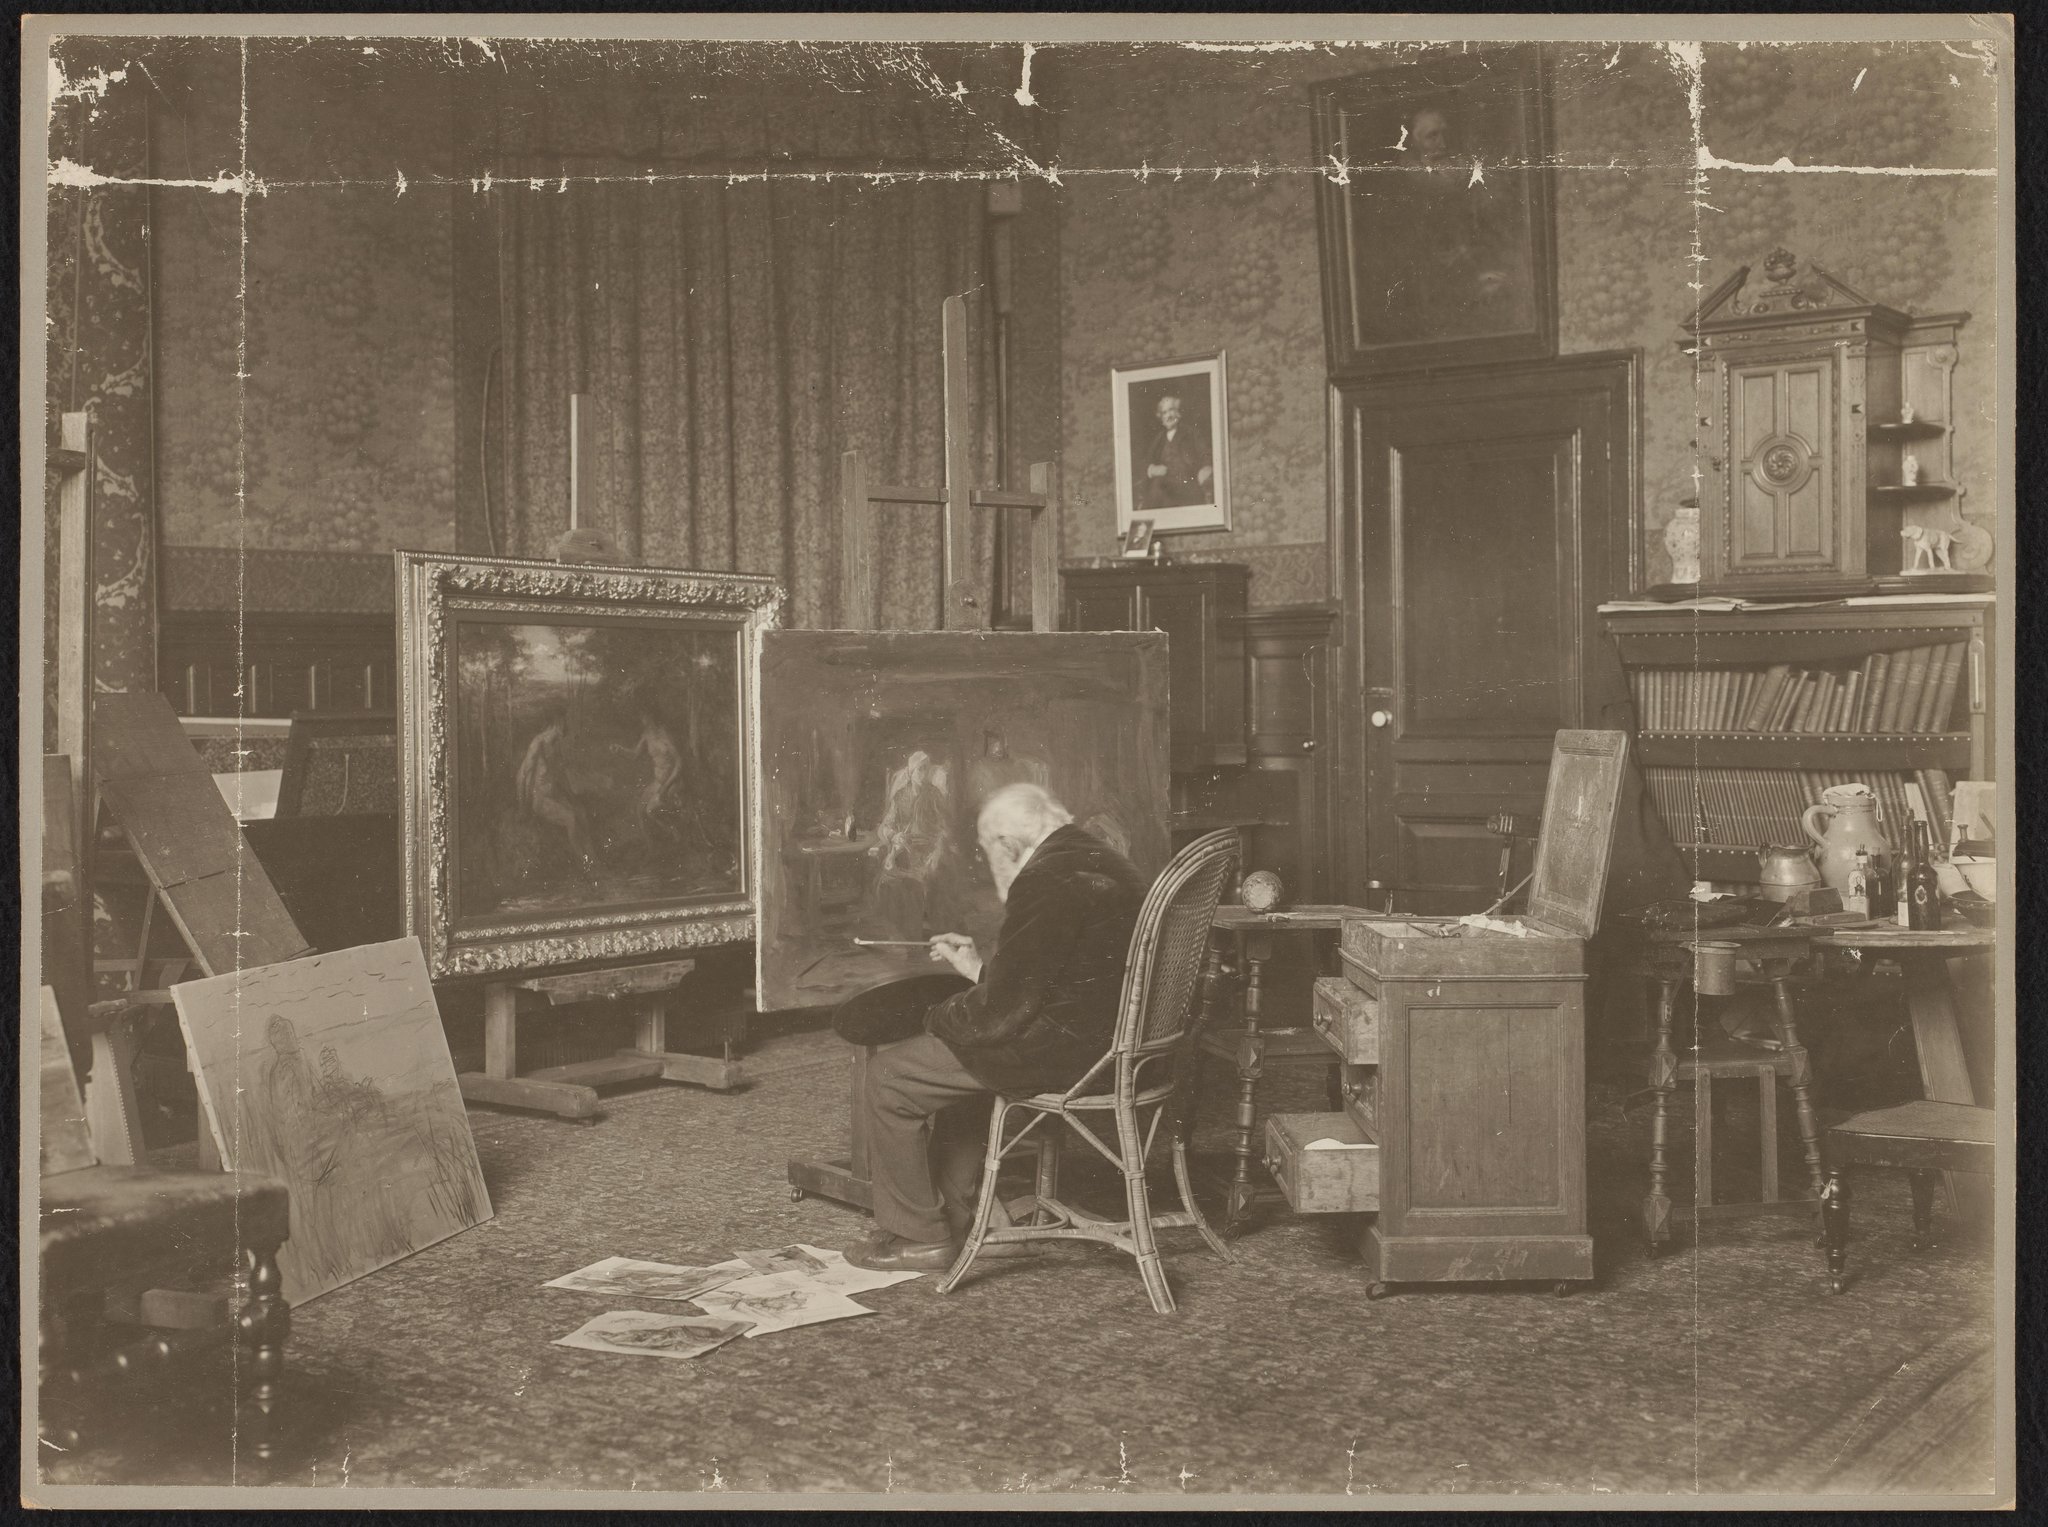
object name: photograph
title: Jozef Israëls in zijn atelier in Den Haag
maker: Anonymous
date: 1900-1911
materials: paper, cardboard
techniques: gelatin silver print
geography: the hague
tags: the hague, painter, print maker, draughtsman, jozef israëls, historical persons, painter at work, in his studio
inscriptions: collector's mark: Lugt 2228